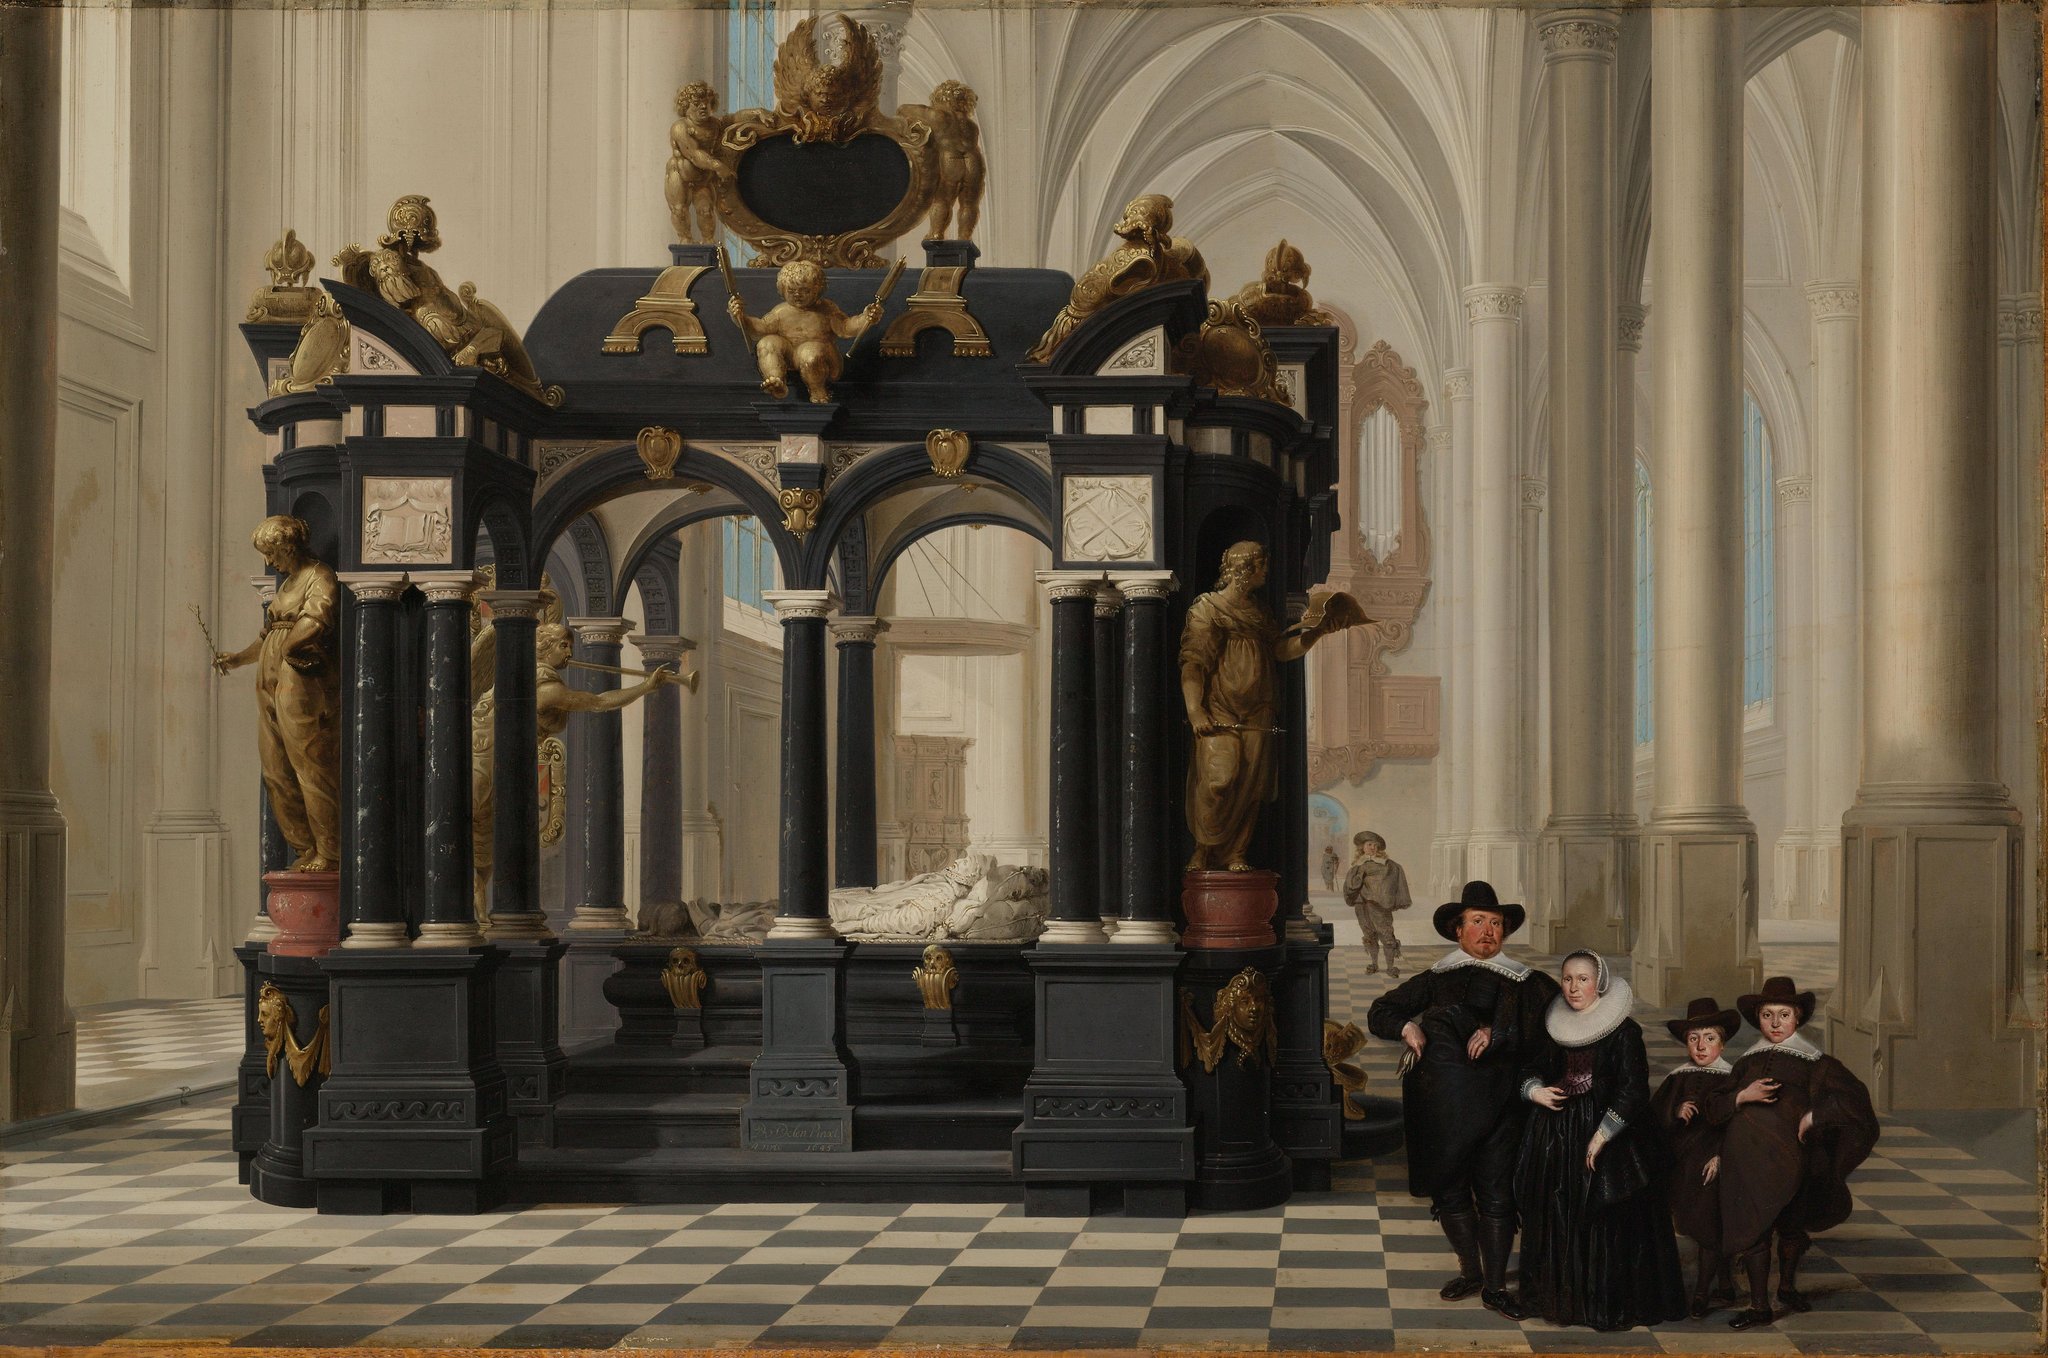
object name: painting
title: A Family beside the Tomb of Prince William i in the Nieuwe Kerk, Delft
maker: dirck van delen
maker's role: painter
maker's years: 1604-1671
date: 1645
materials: oil, panel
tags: delft, william i (prince of orange), family group, especially parents with their child(ren), grave-building, monumental tomb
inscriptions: signature and date: ‘DvDelen Pinxt. Anno 1645.’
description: The tomb of William of Orange became a much-visited attraction from the moment it was completed in 1621. People like this family – a father, mother and two sons, all dressed in restrained, decorous black – even had painters immortalize them standing next to the monument as evidence of their solidarity with the ‘Father of the Fatherland’.